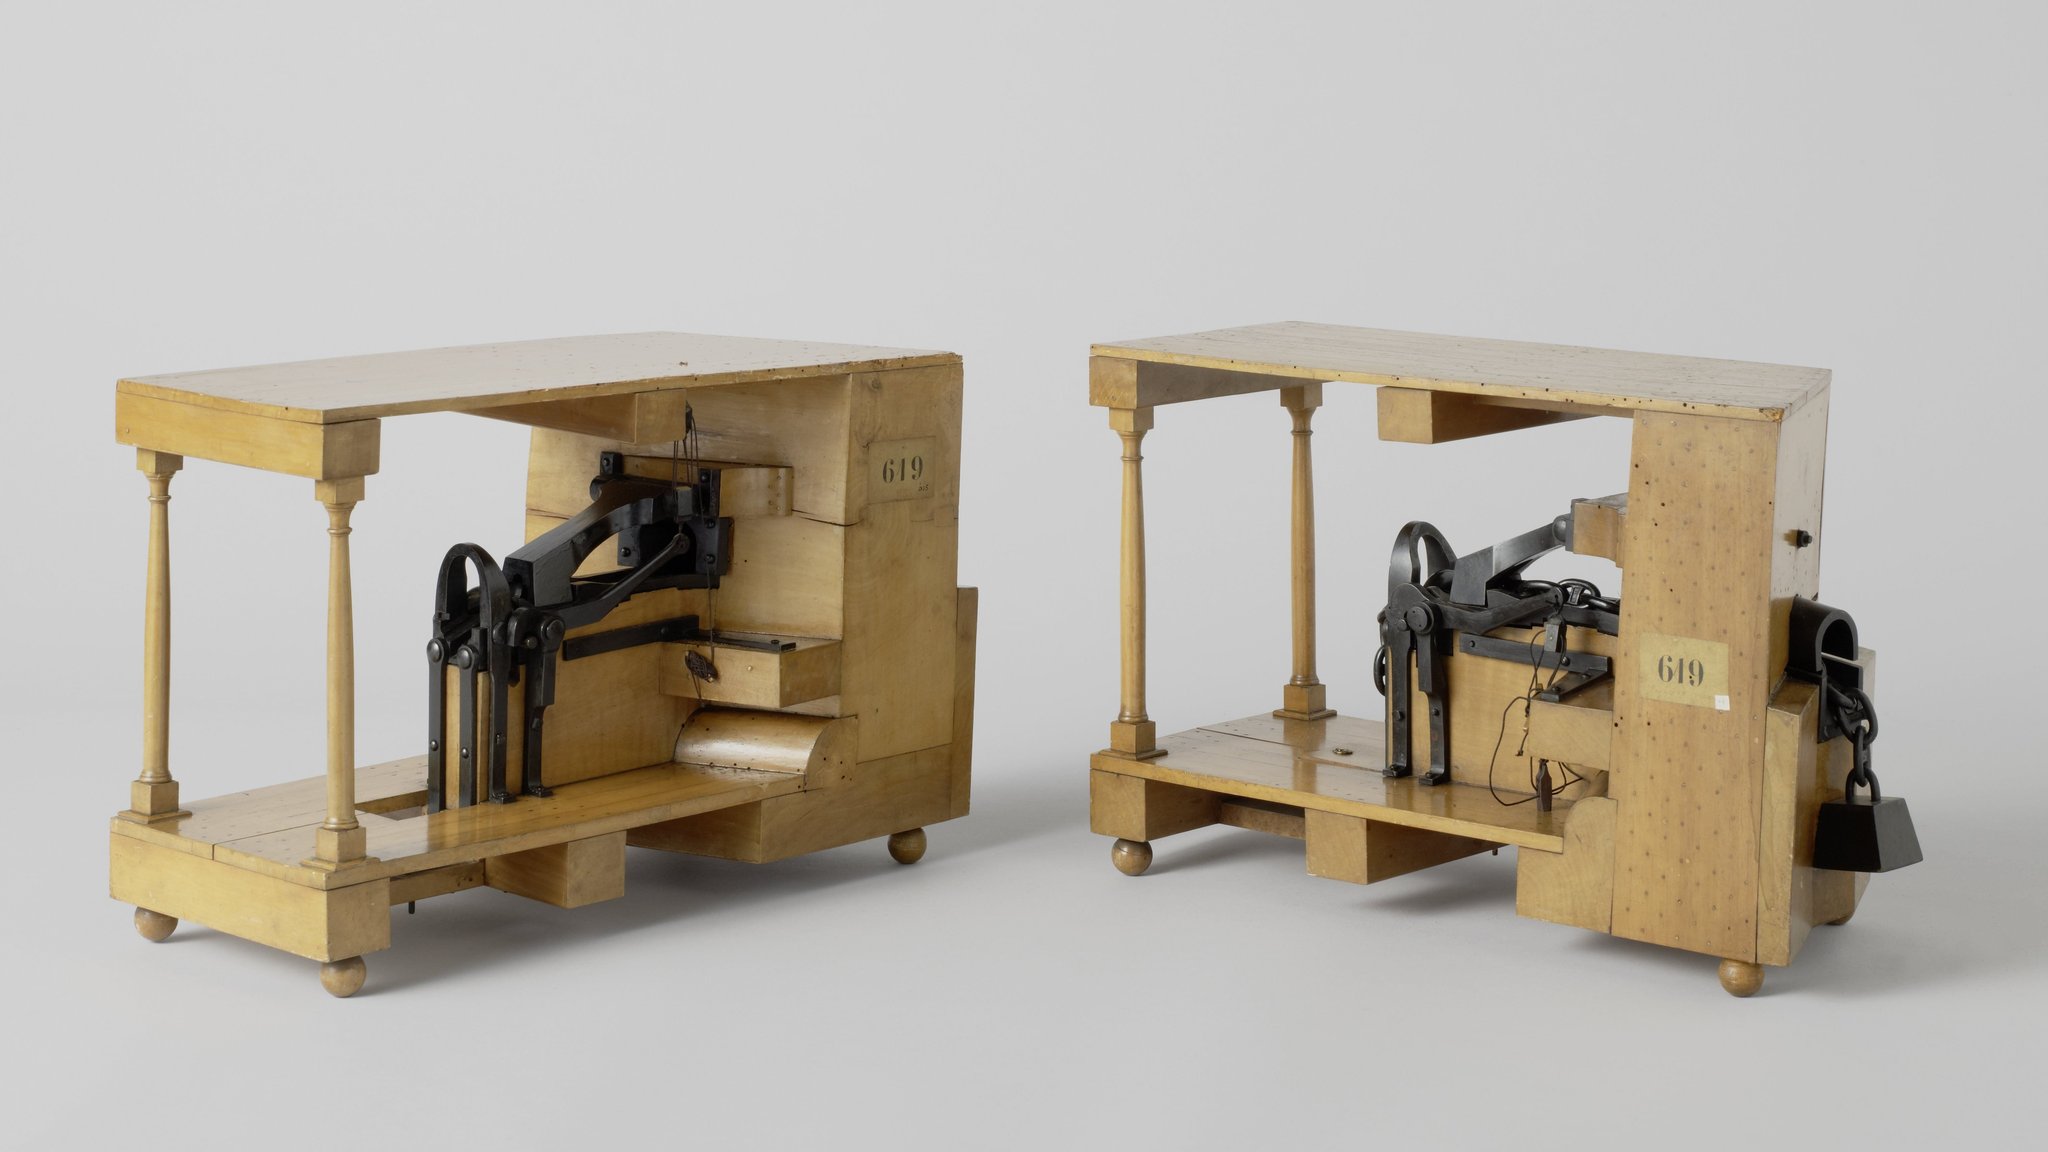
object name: demonstration model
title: Two Models of a Chain Stopper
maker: Anonymous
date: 1833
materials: fiber, wood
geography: netherlands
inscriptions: label, centre right: ‘619’ former inventory label, label, upper right: ‘619 bis’ former inventory label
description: Twee identieke modellen van een kettingstopper tussen twee dekken, bestaande uit een glijbaan voor de ketting op een klos en doorlopend door het bakboord kluisgat, en een zware duivelsklauw hangend aan een klos aan de scheepswand. Een houten ketting met namaakgewicht is aan het model toegevoegd. Schaal 1:10 (schatting).